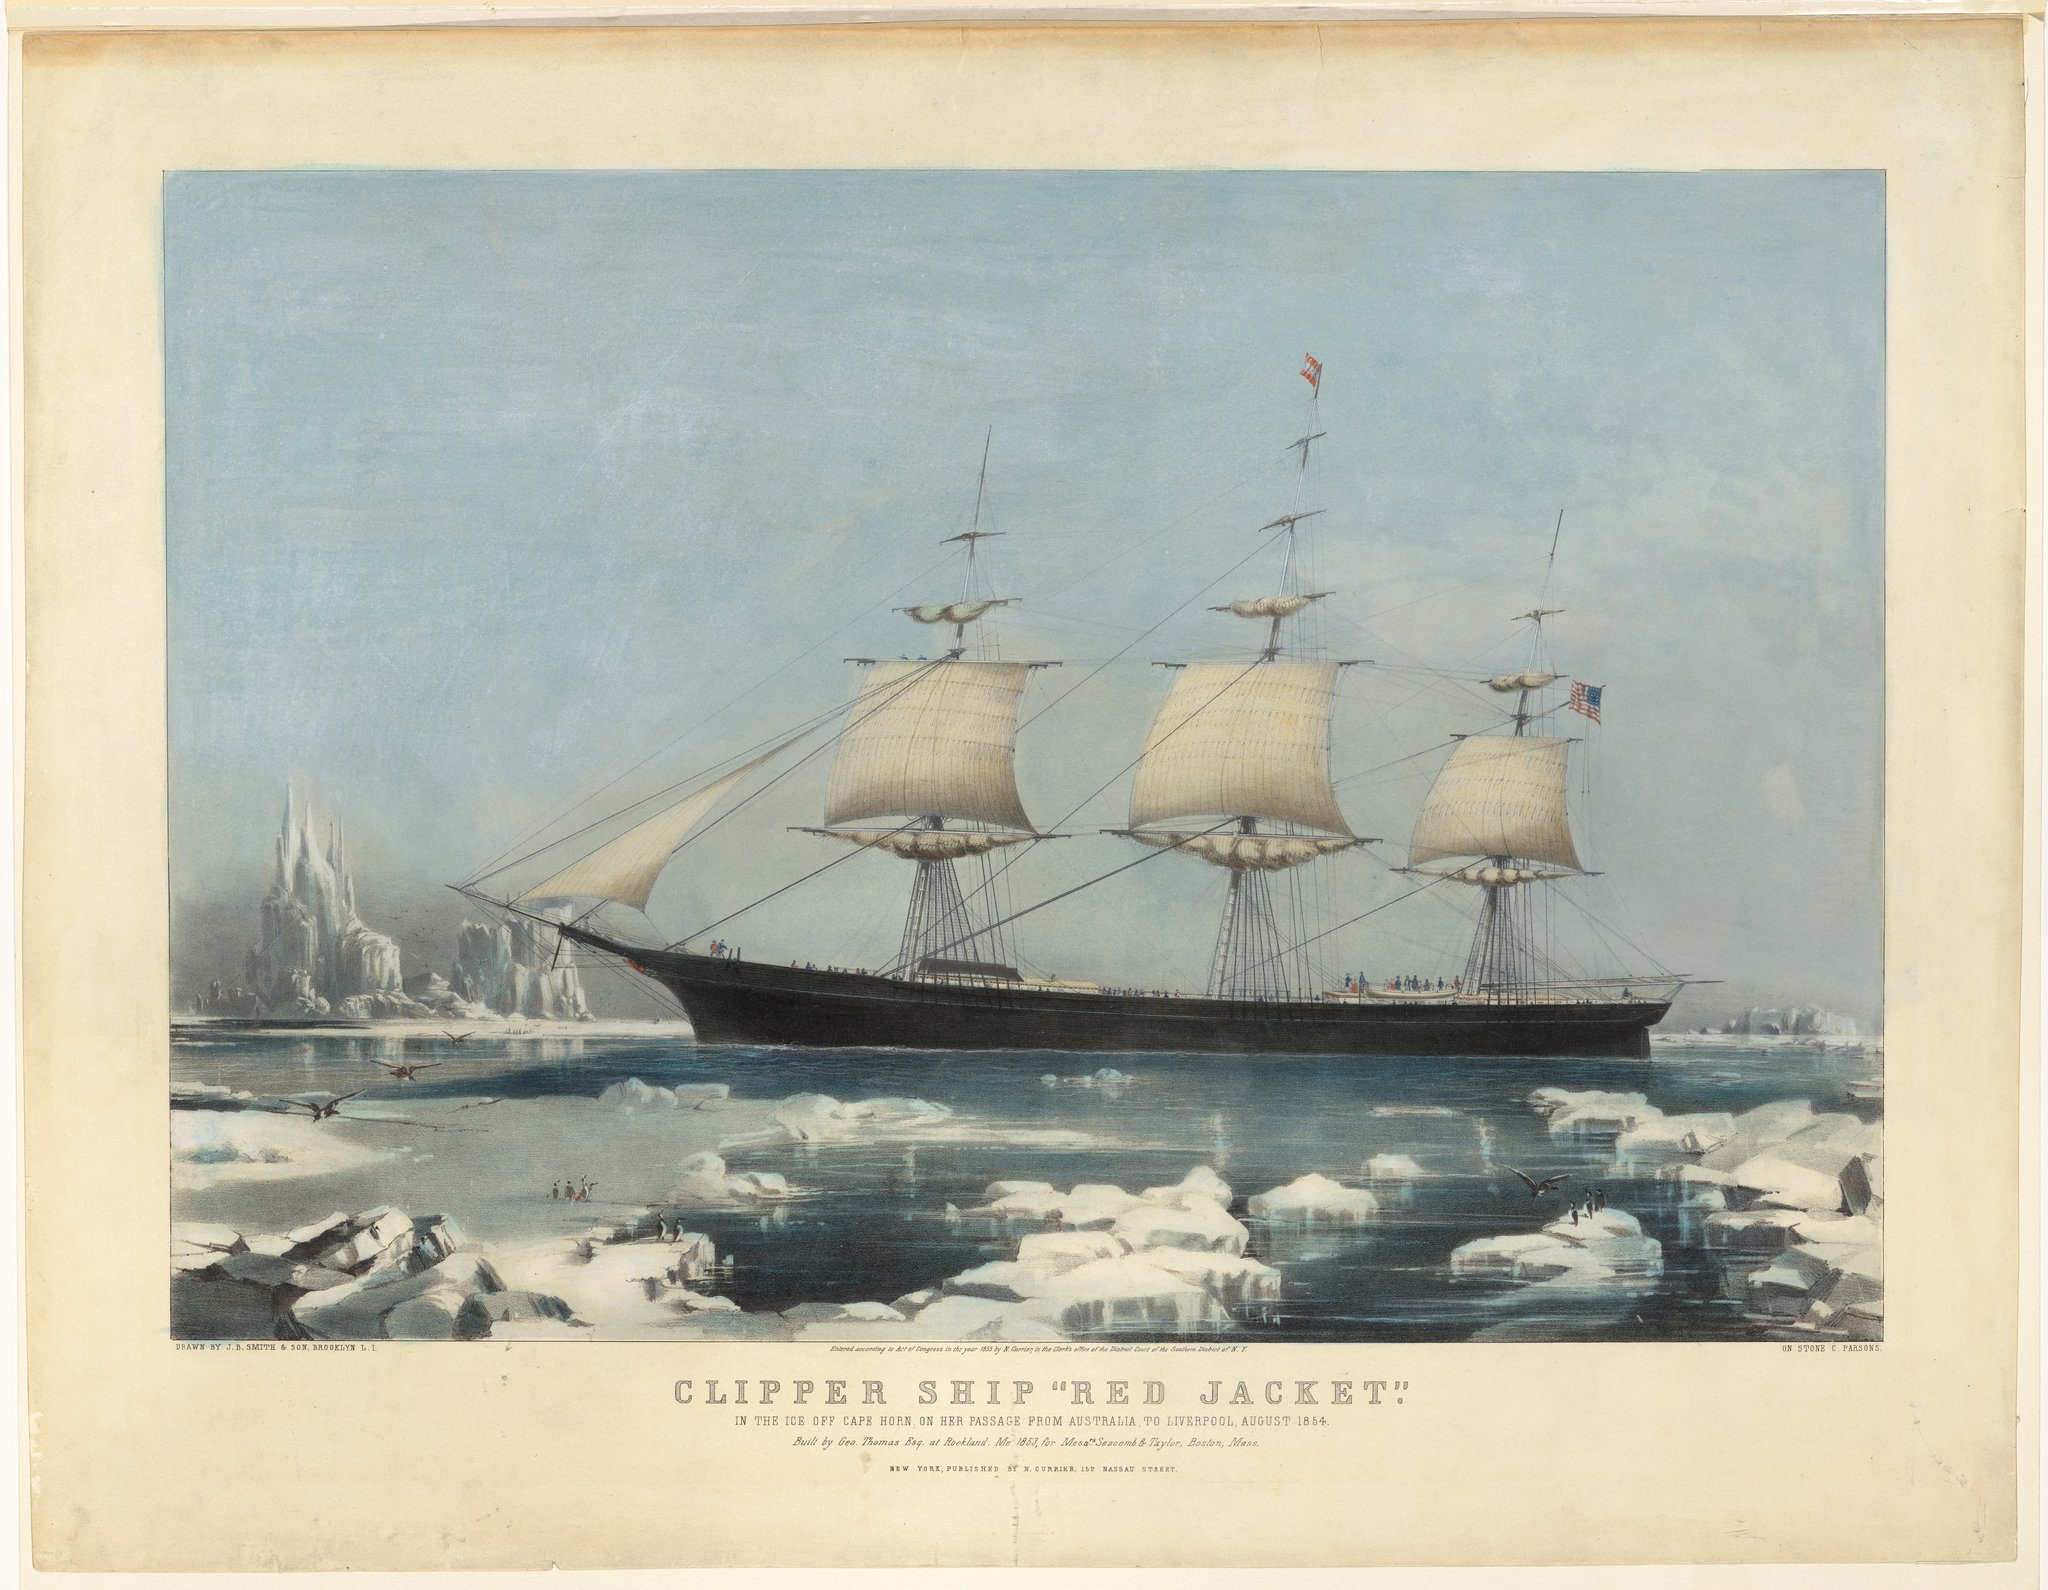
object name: print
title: Clipper Ship "Red Jacket" – In the Ice off Cape Horn, on Her Passage from Australia, to Liverpool, August 1854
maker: charles parsons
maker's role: artist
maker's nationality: american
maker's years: 1821-1910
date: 1855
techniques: hand coloring, lithograph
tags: ships